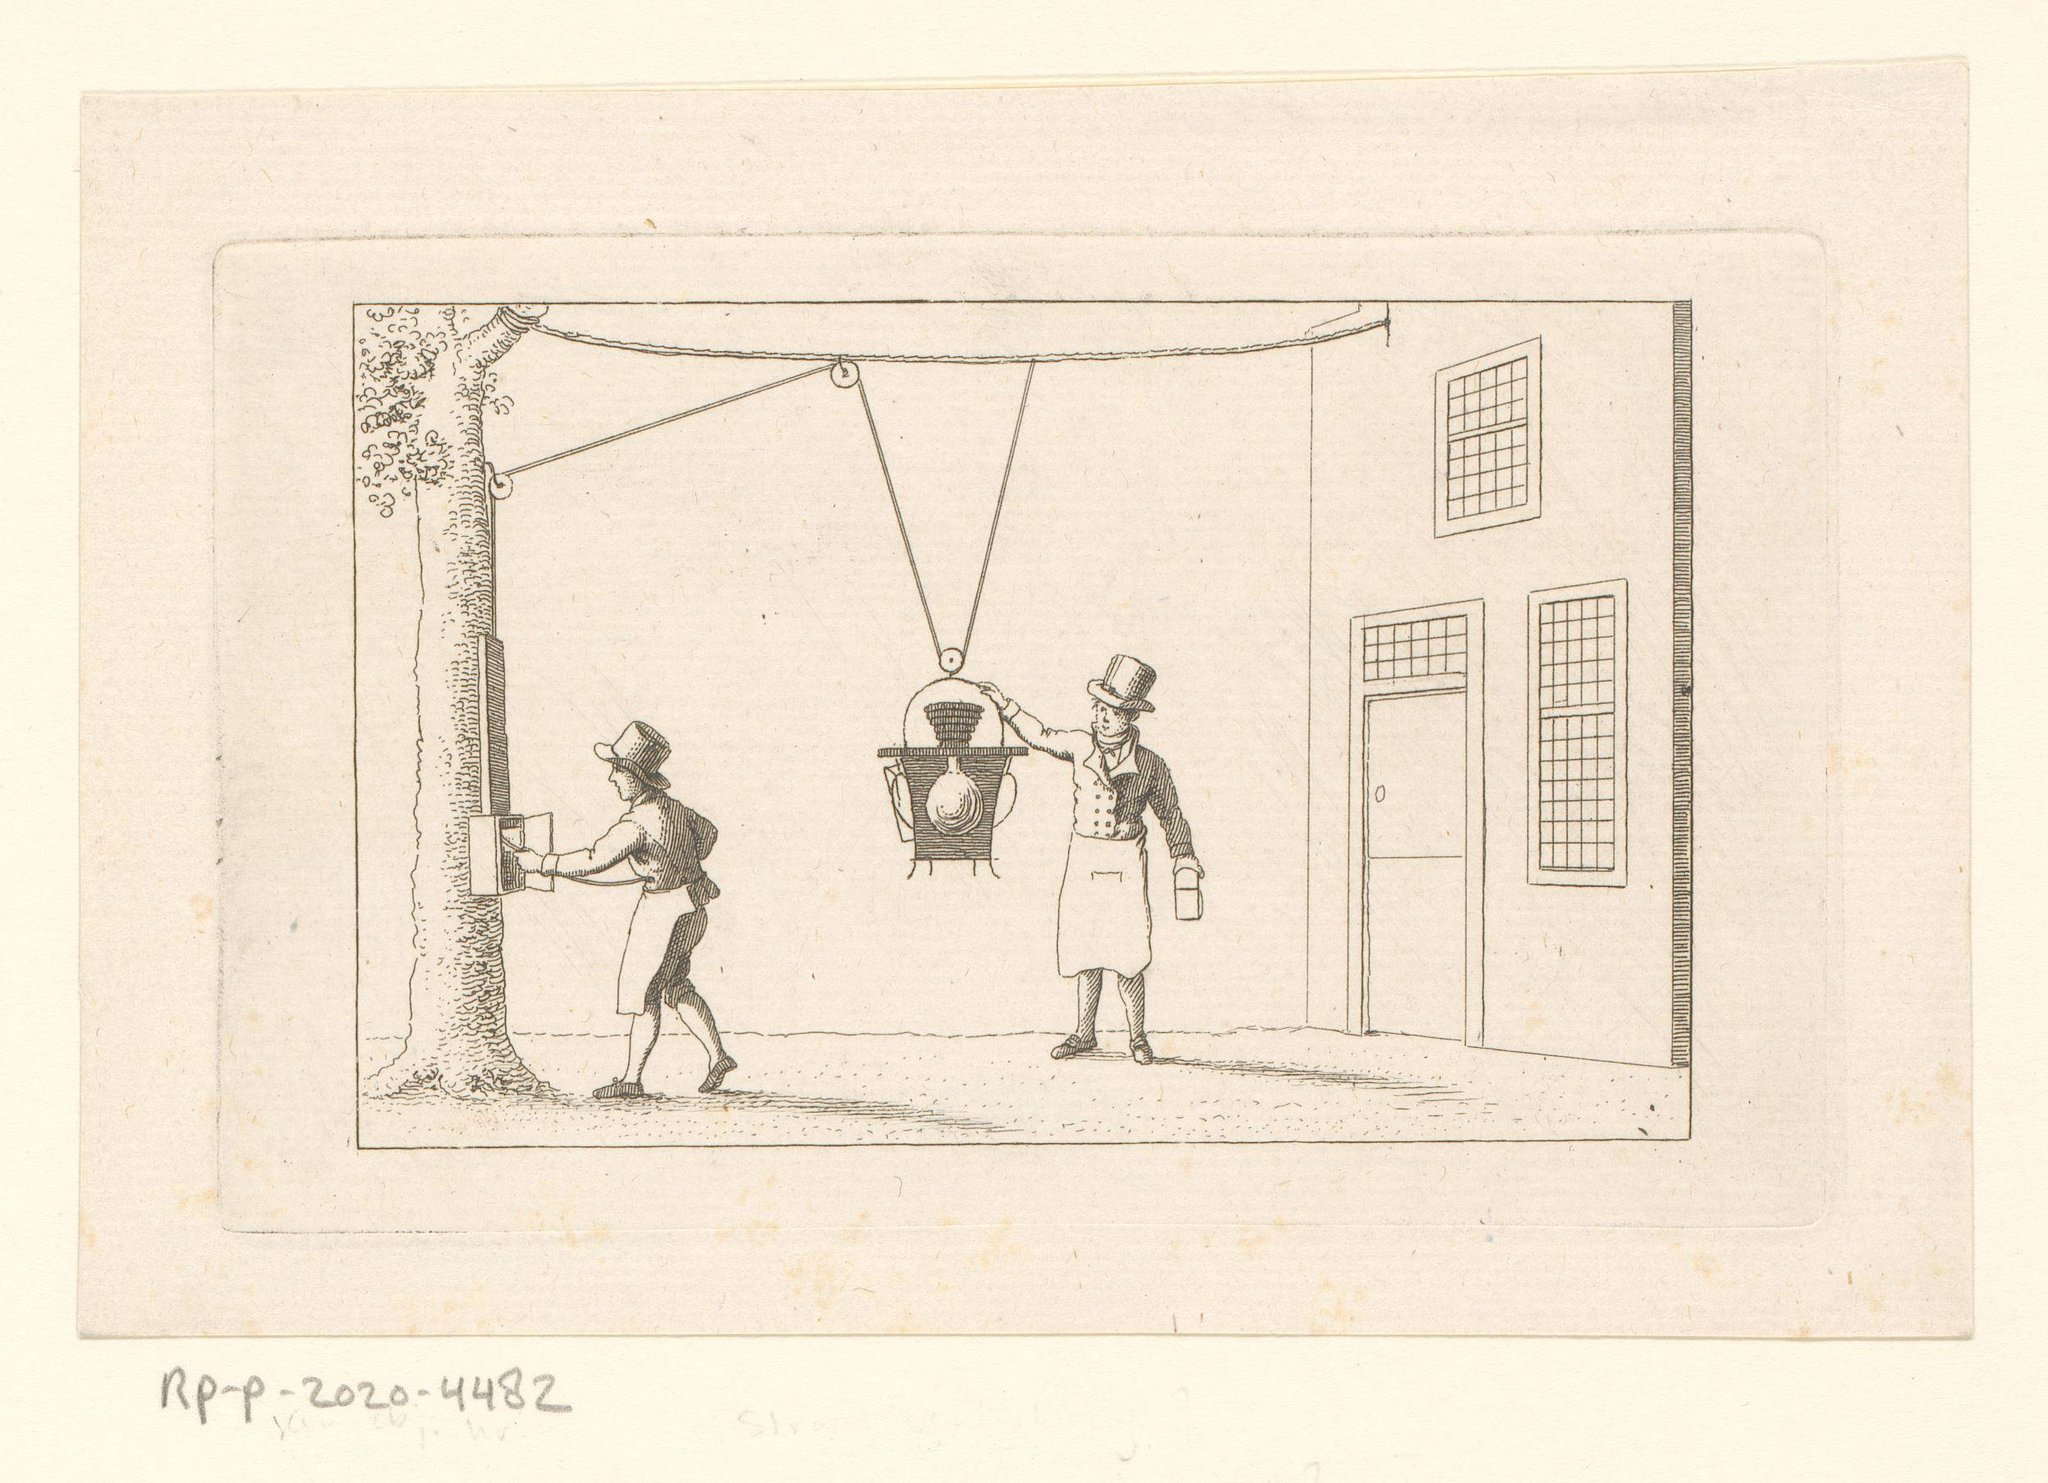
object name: print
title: Twee mannen bezig met het ophangen van straatverlichting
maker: Anonymous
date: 1800-1900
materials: paper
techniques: etching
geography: netherlands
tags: street lighting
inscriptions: collector's mark: Lugt 2228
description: Twee mannen zijn met een katrol bezig iets omhoog te hijsen, vermoedelijk straatverlichting.